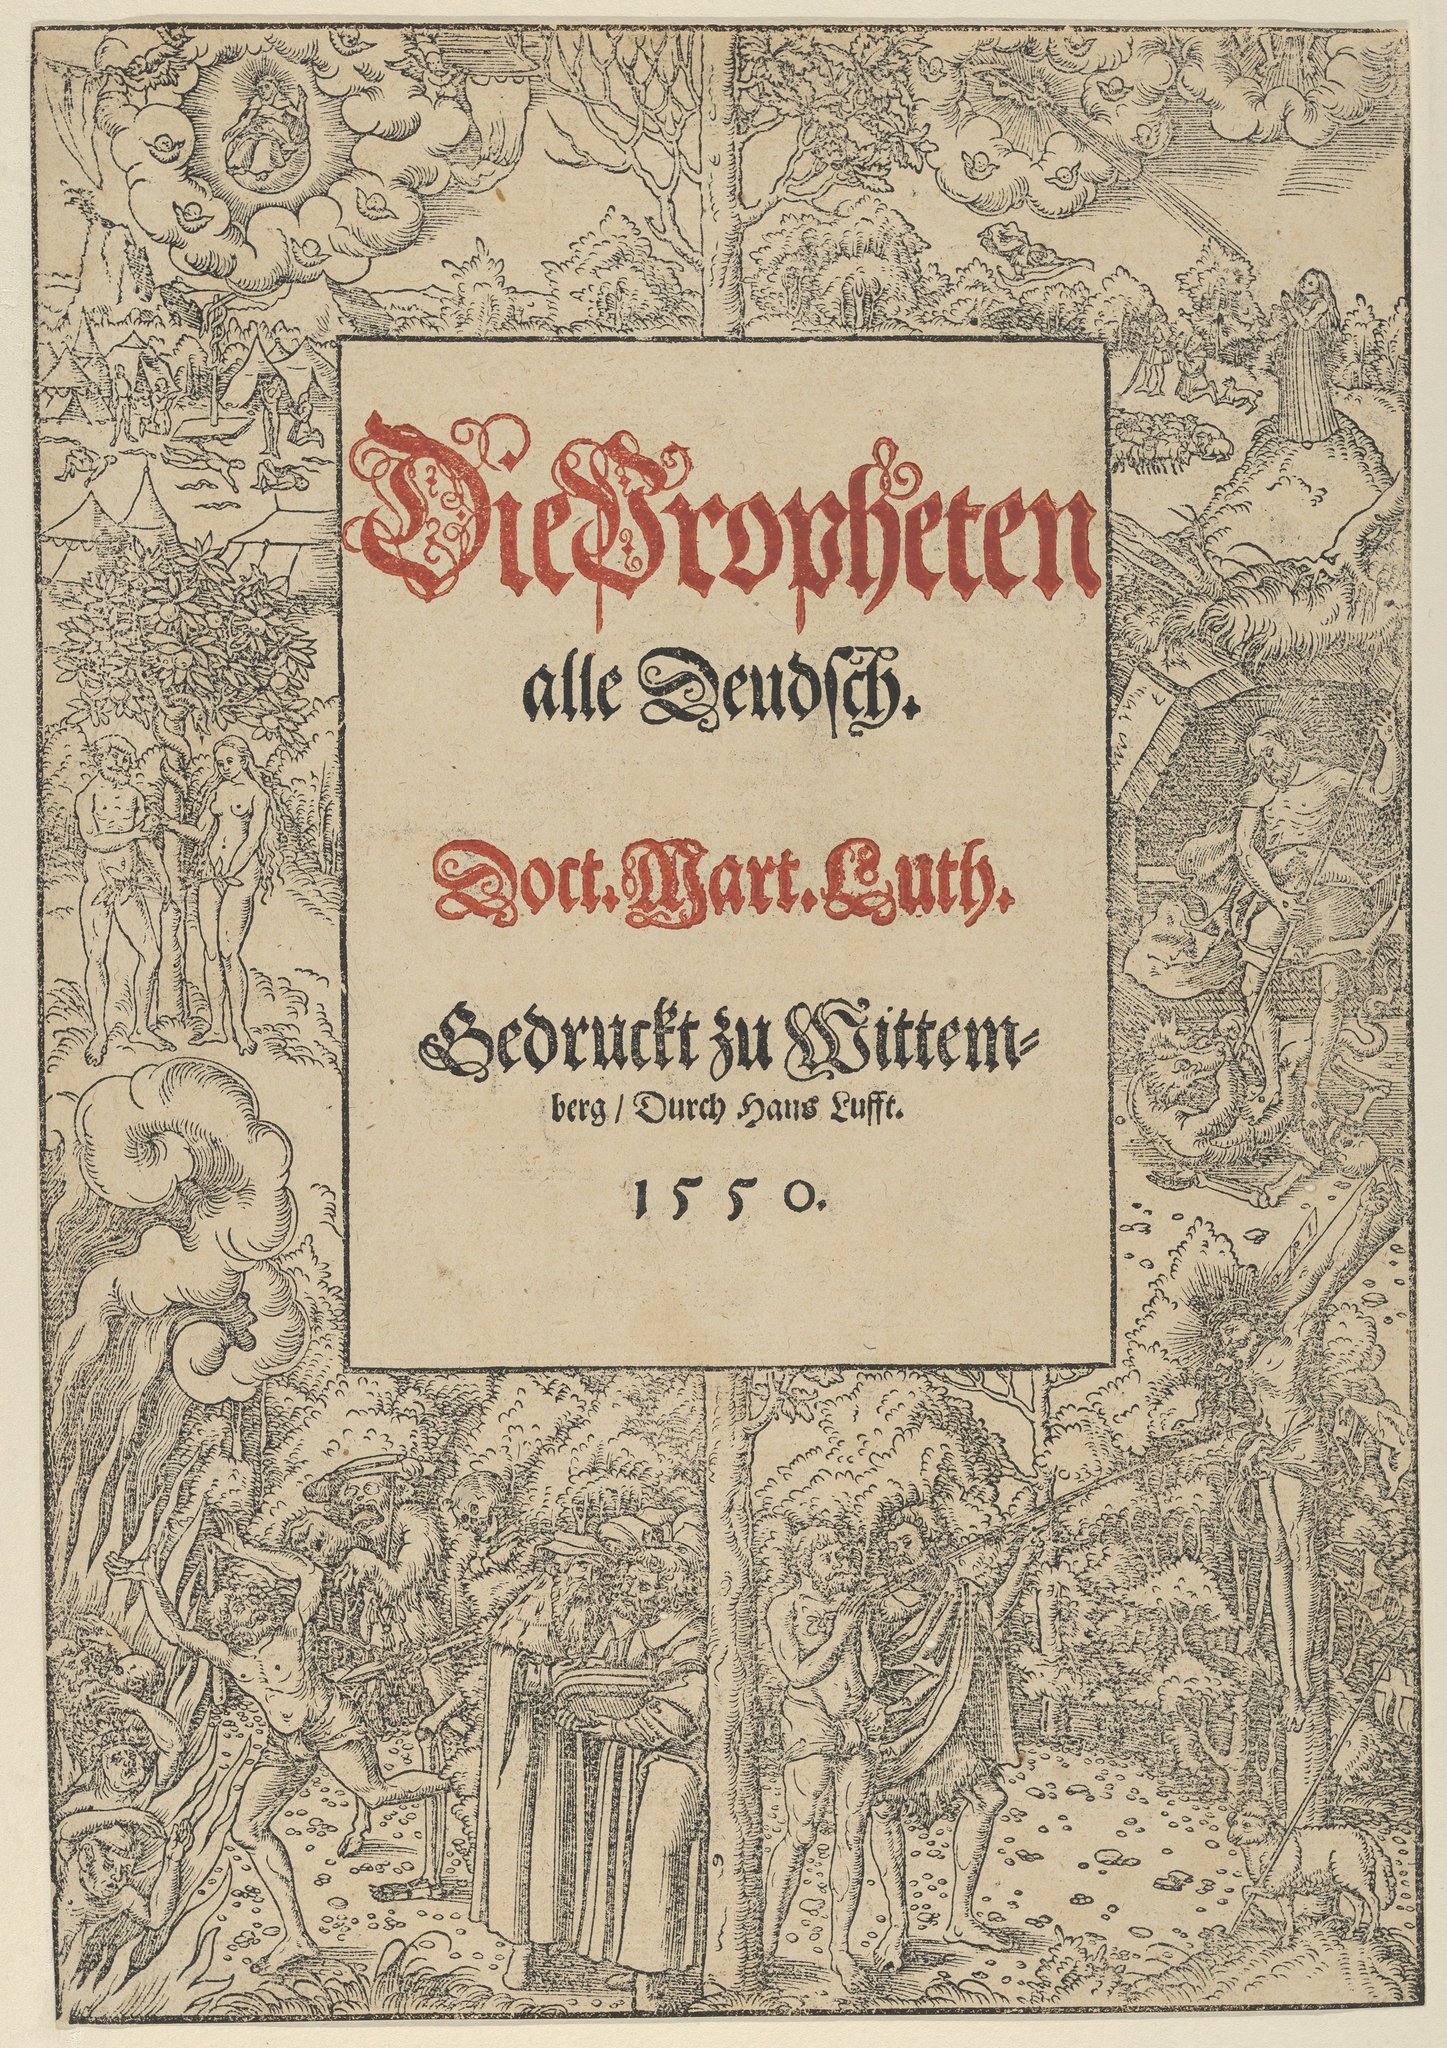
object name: print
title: Die Propheten alle Deudsch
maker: lucas cranach the younger and workshop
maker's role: artist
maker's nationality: german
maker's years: 1515-1586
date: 1541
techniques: woodcut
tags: men,women,female nudes